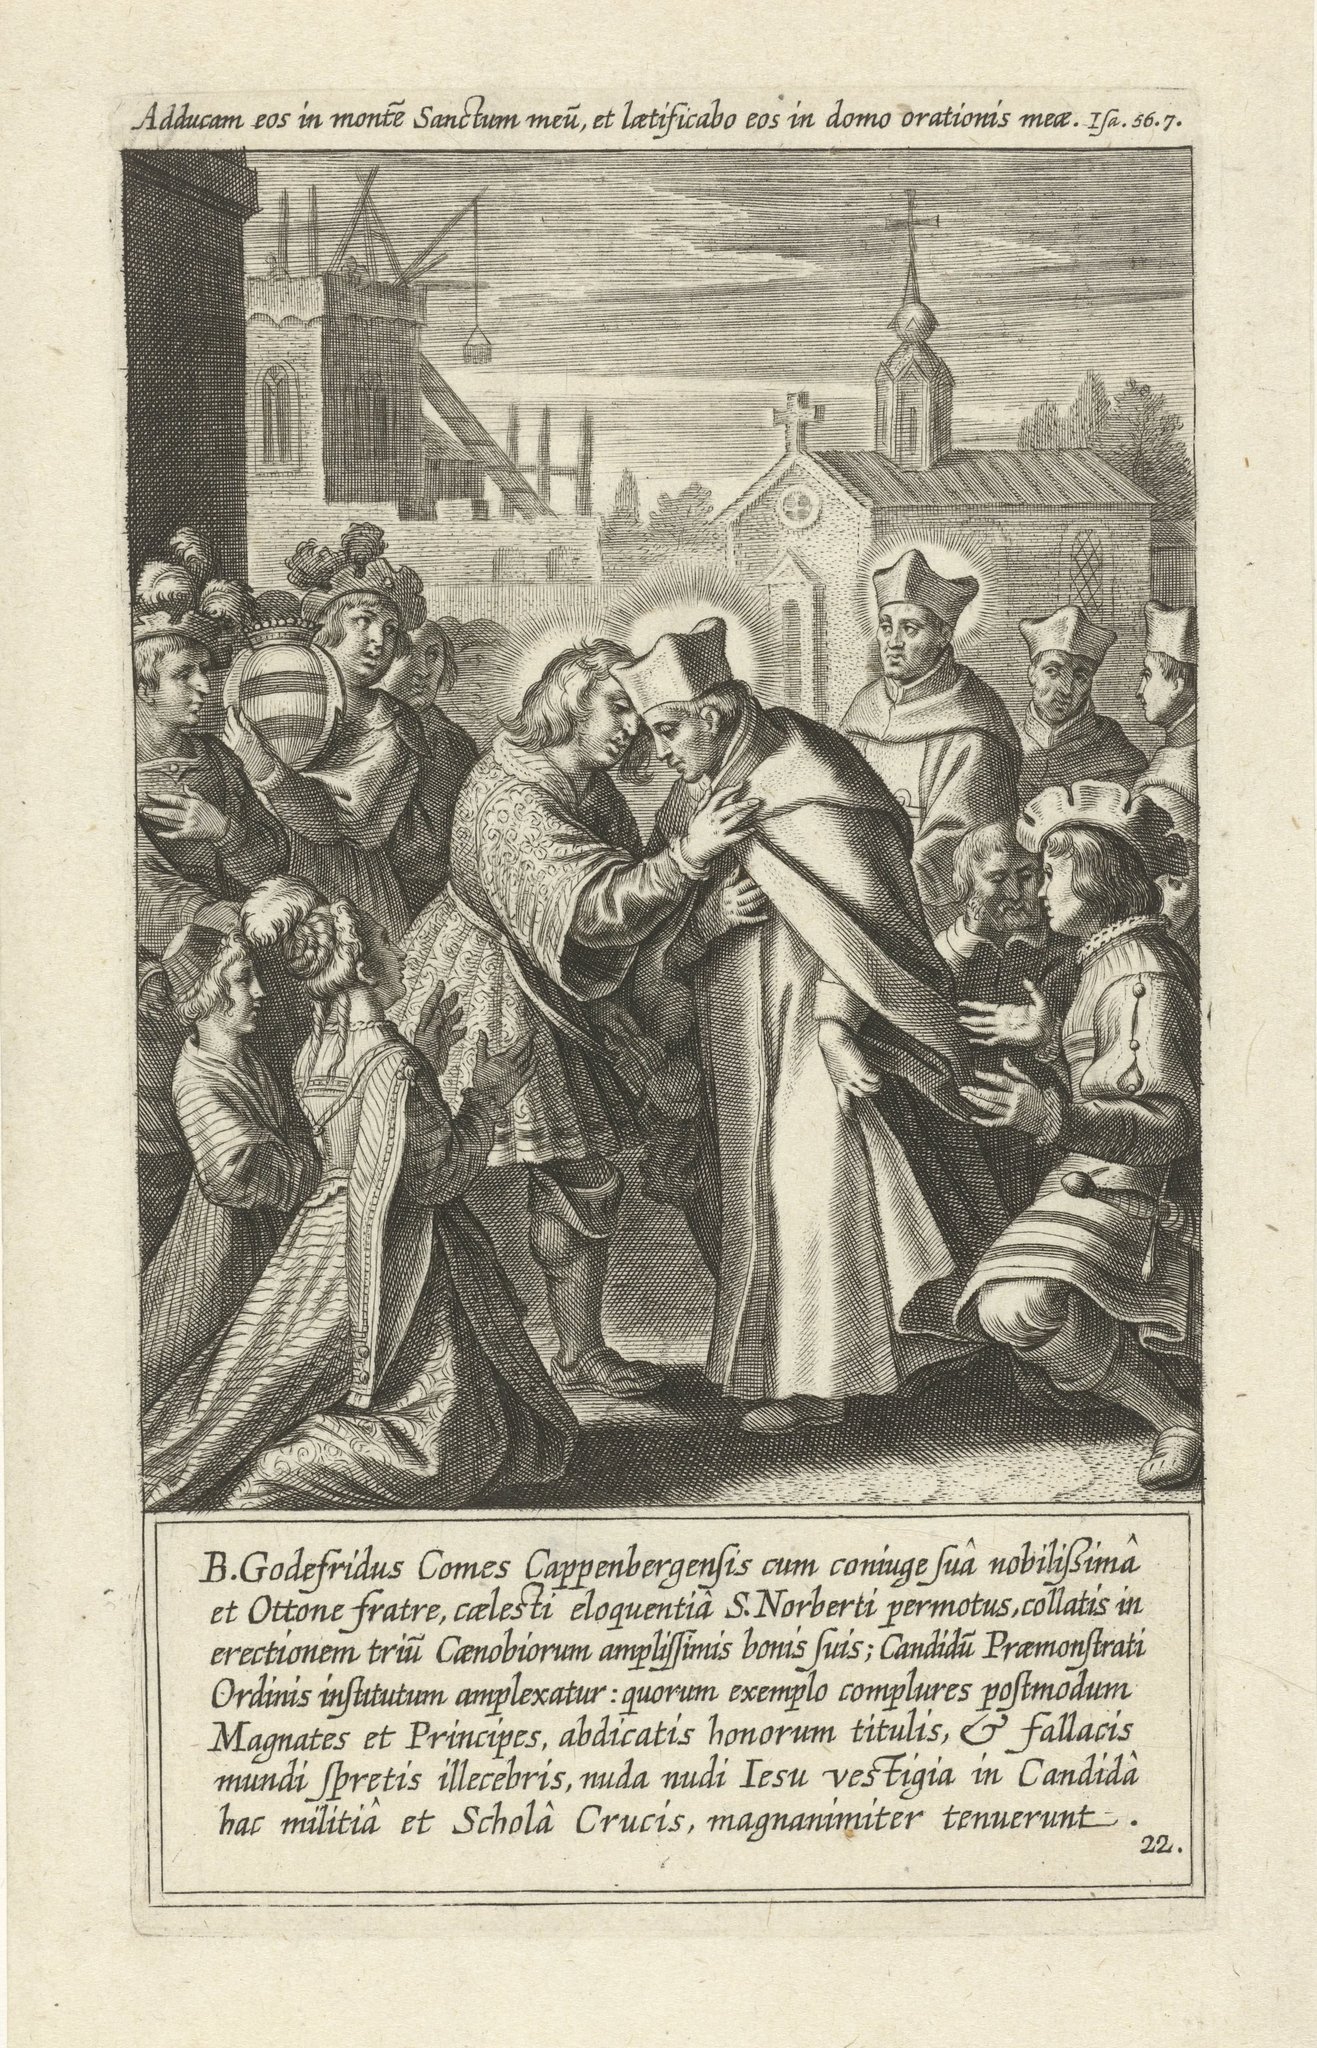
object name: book illustration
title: Ontmoeting tussen graaf Godfried van Cappenberg en de heilige Norbertus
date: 1622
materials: paper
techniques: engraving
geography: antwerp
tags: non-miraculous activities and events ~ st. norbert, male saints (with name)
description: De graaf van Westfalen, Godfried van Cappenberg, ontmoet de heilige Norbertus. Hij schenkt al zijn bezittingen aan de orde van de Norbertijnen. De prent heeft twee Latijnse opschriften: een boven en een onder de voorstelling.